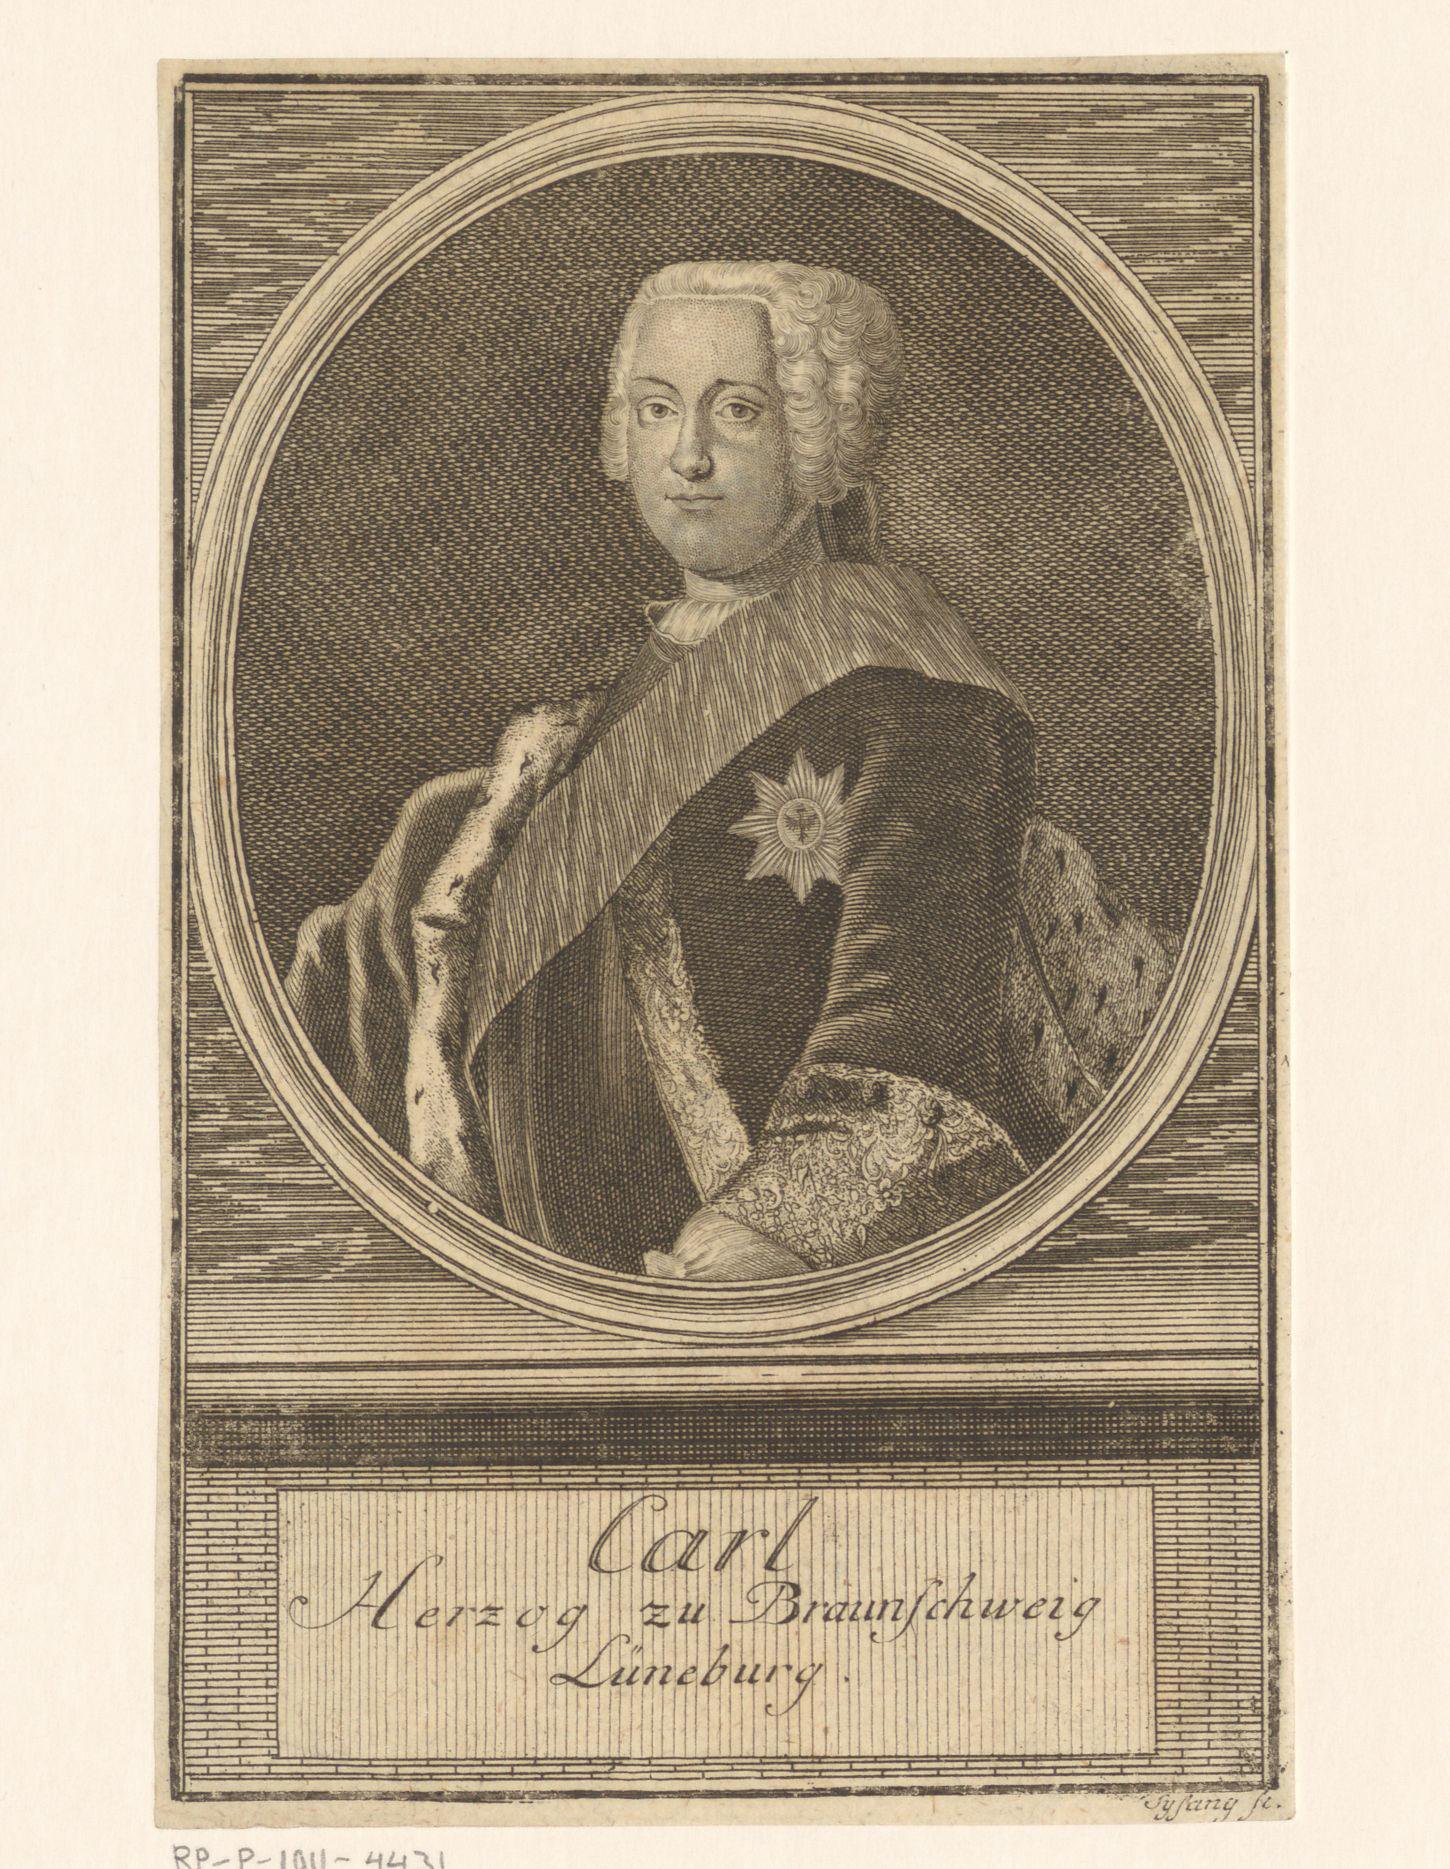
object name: print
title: Portret van Carl I von Braunschweig-Wolfenbüttel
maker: johann christoph sysang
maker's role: print maker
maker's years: 1703-1757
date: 1740-1757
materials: paper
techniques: engraving, etching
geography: leipzig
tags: carl i von braunschweig-wolfenbüttel, historical persons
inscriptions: collector's mark: Lugt 2228